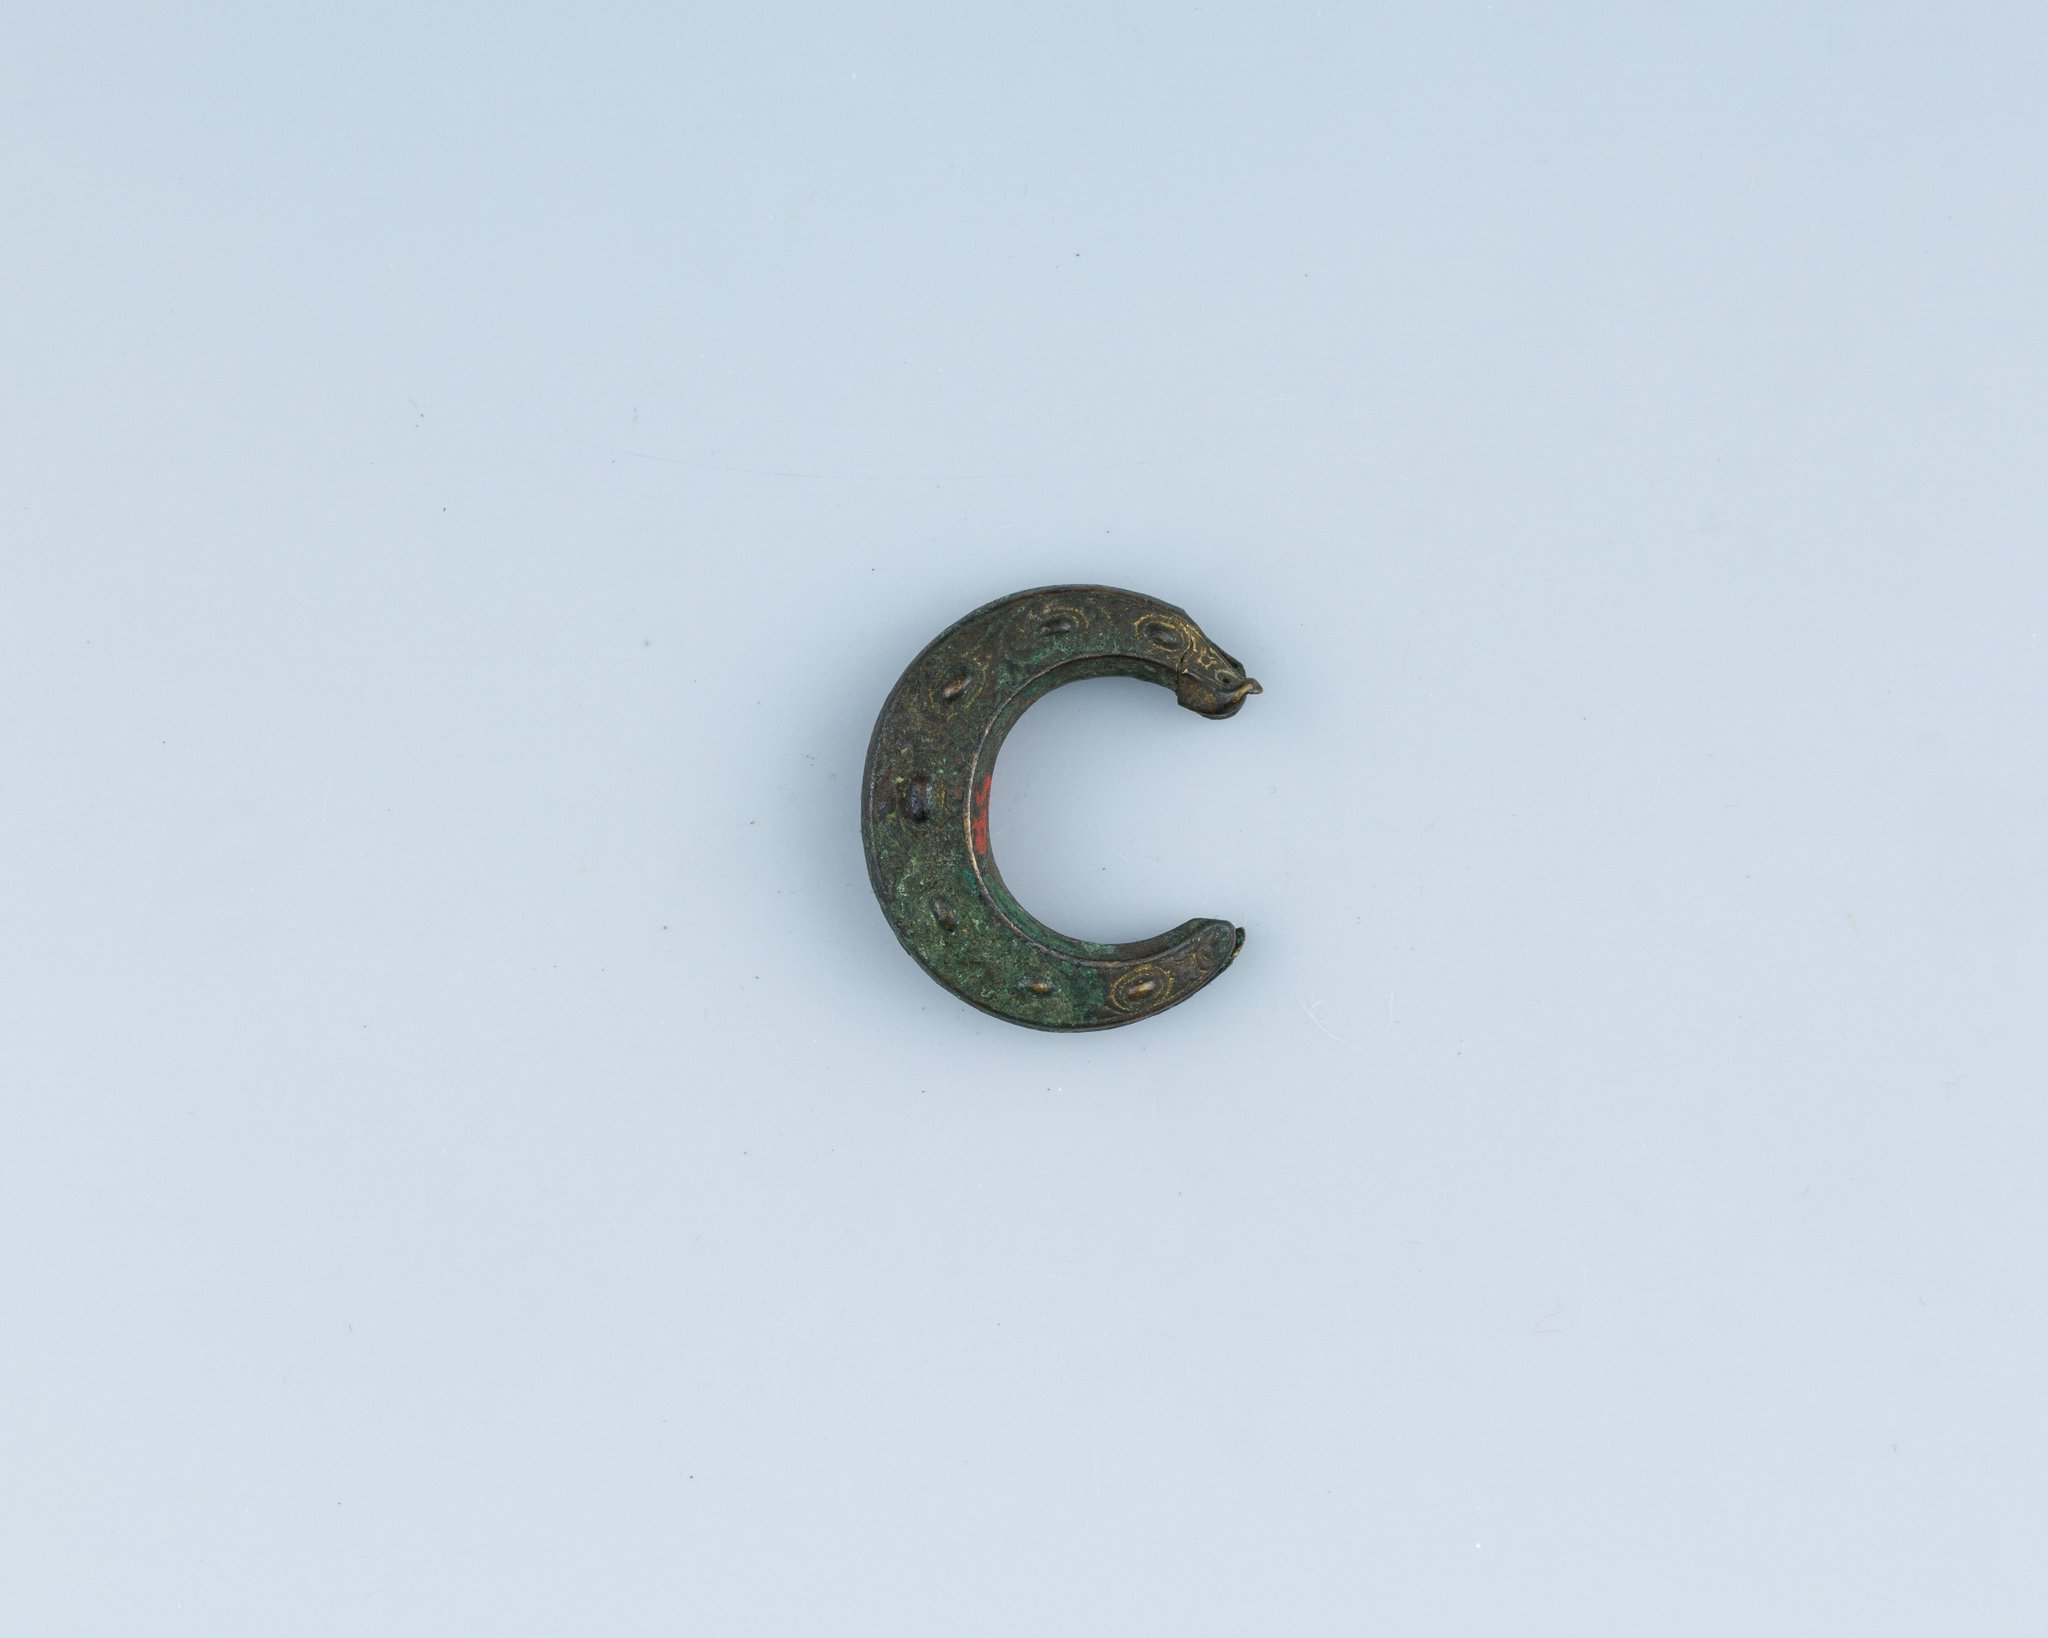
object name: buckle loop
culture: european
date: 1401-1700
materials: bronze, gilt